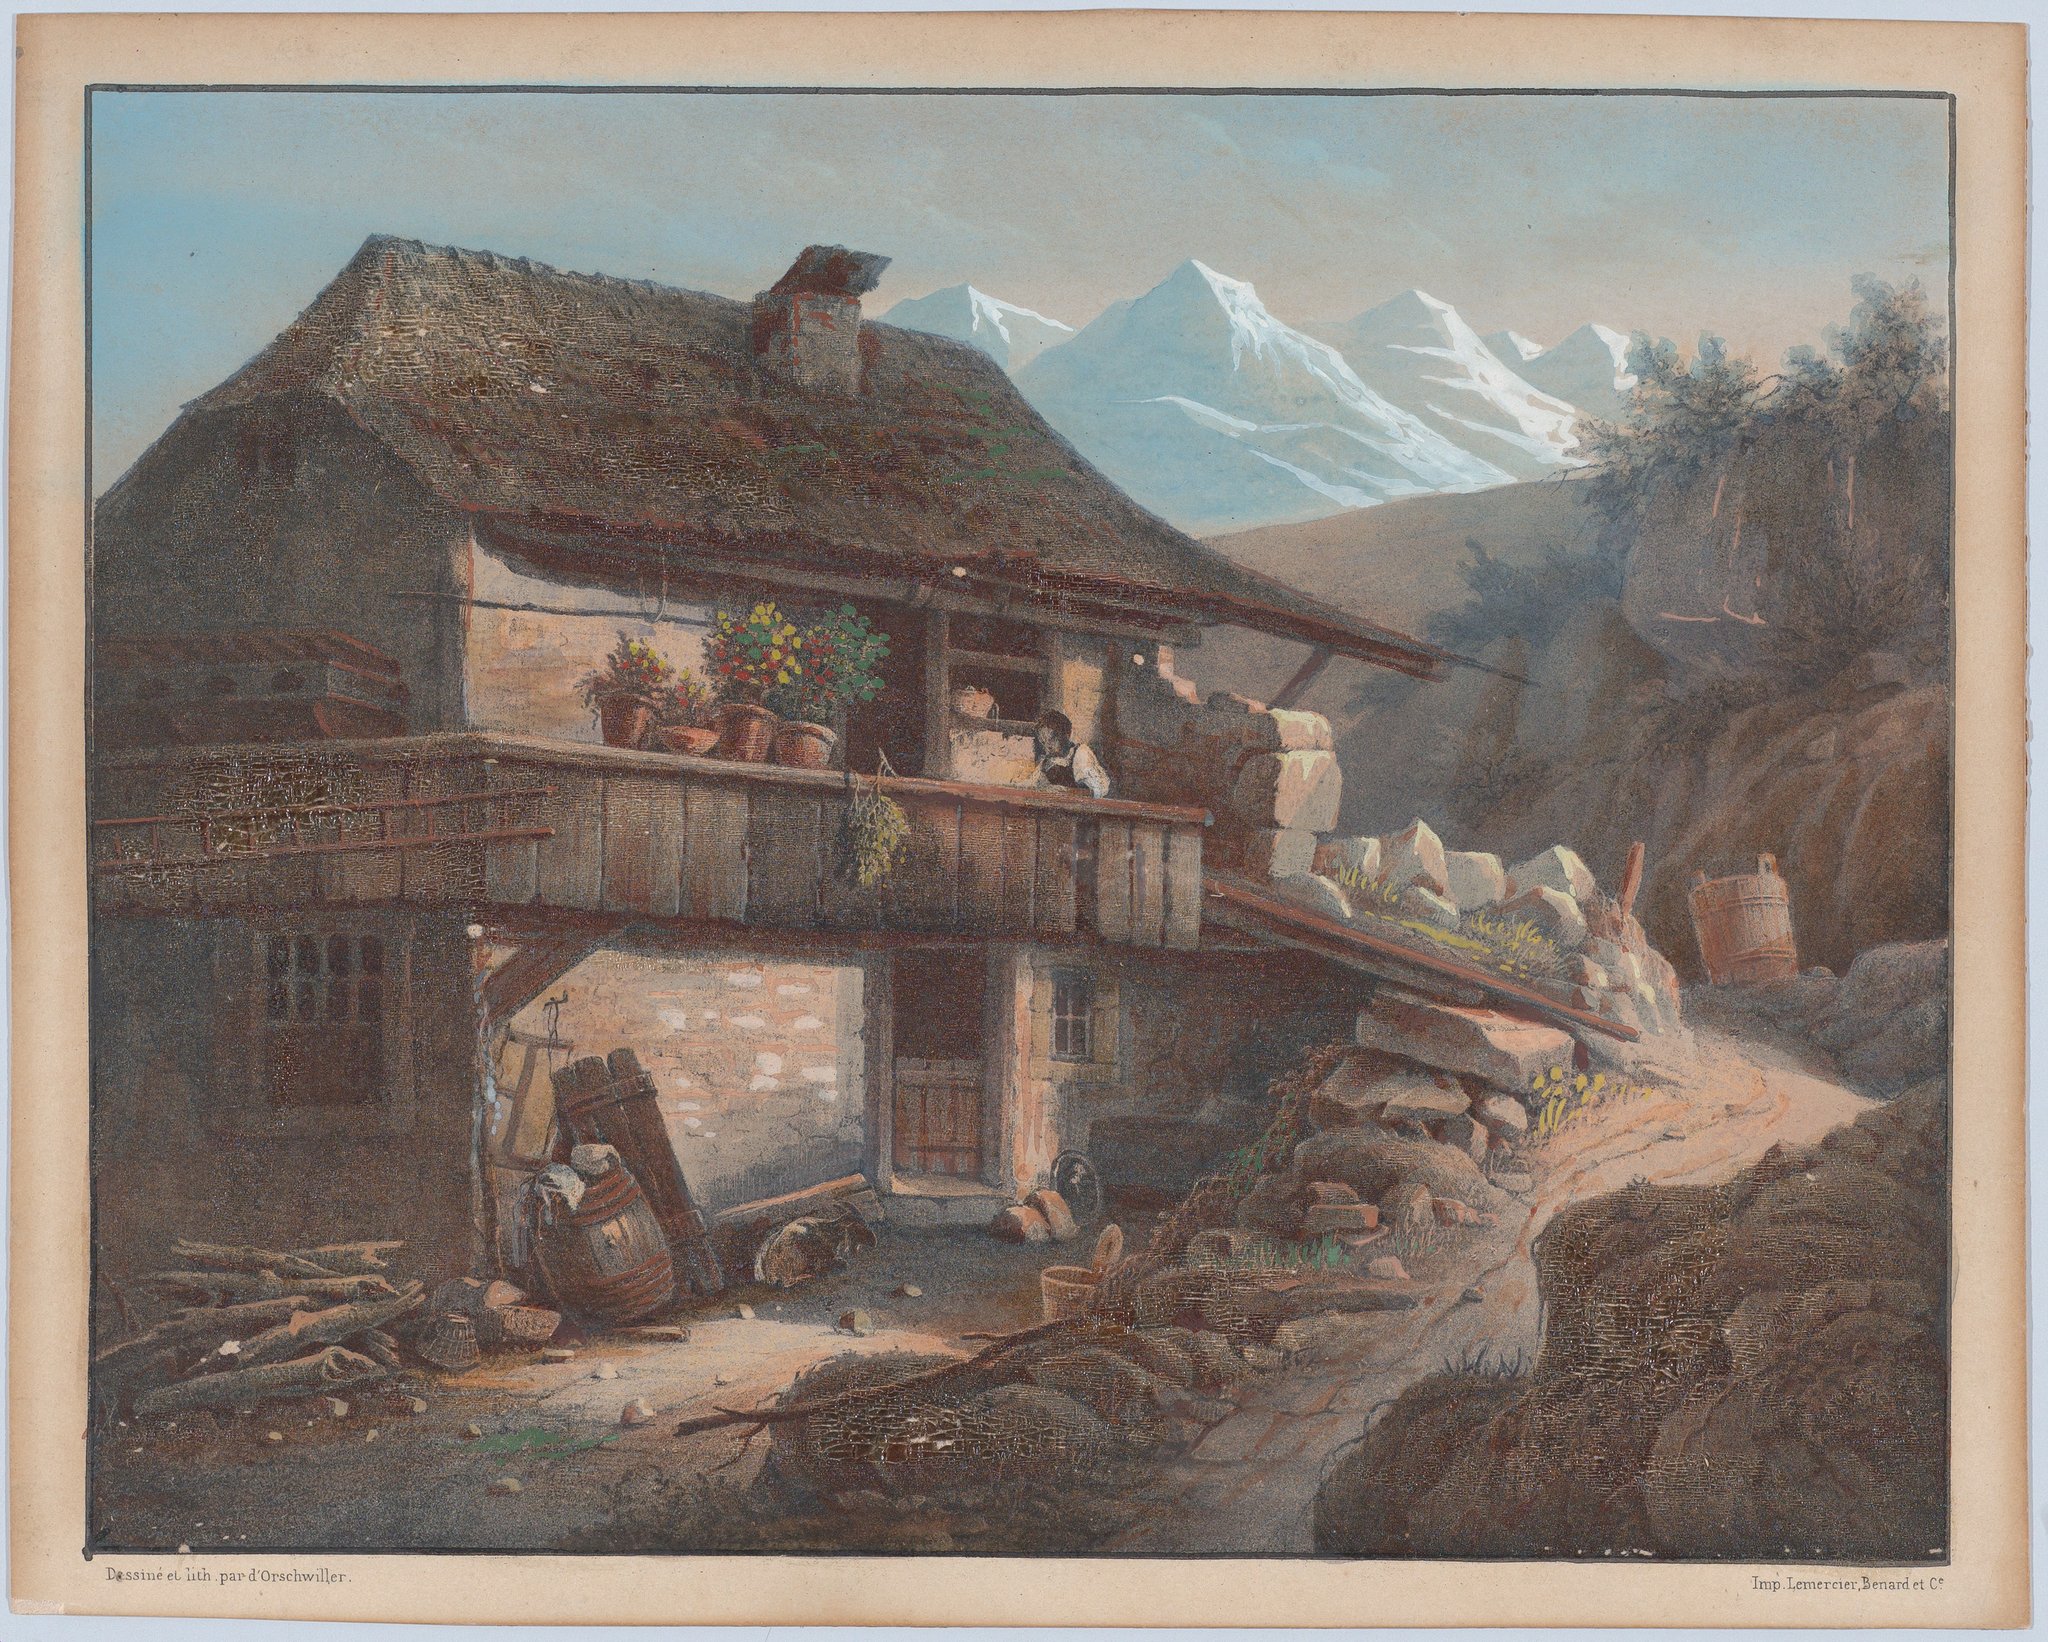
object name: print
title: Alpine Scene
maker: henri boug d'orschwiller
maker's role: artist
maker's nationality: french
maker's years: 1783-1859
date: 1801-1850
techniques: hand coloring, lithograph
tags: houses,mountains